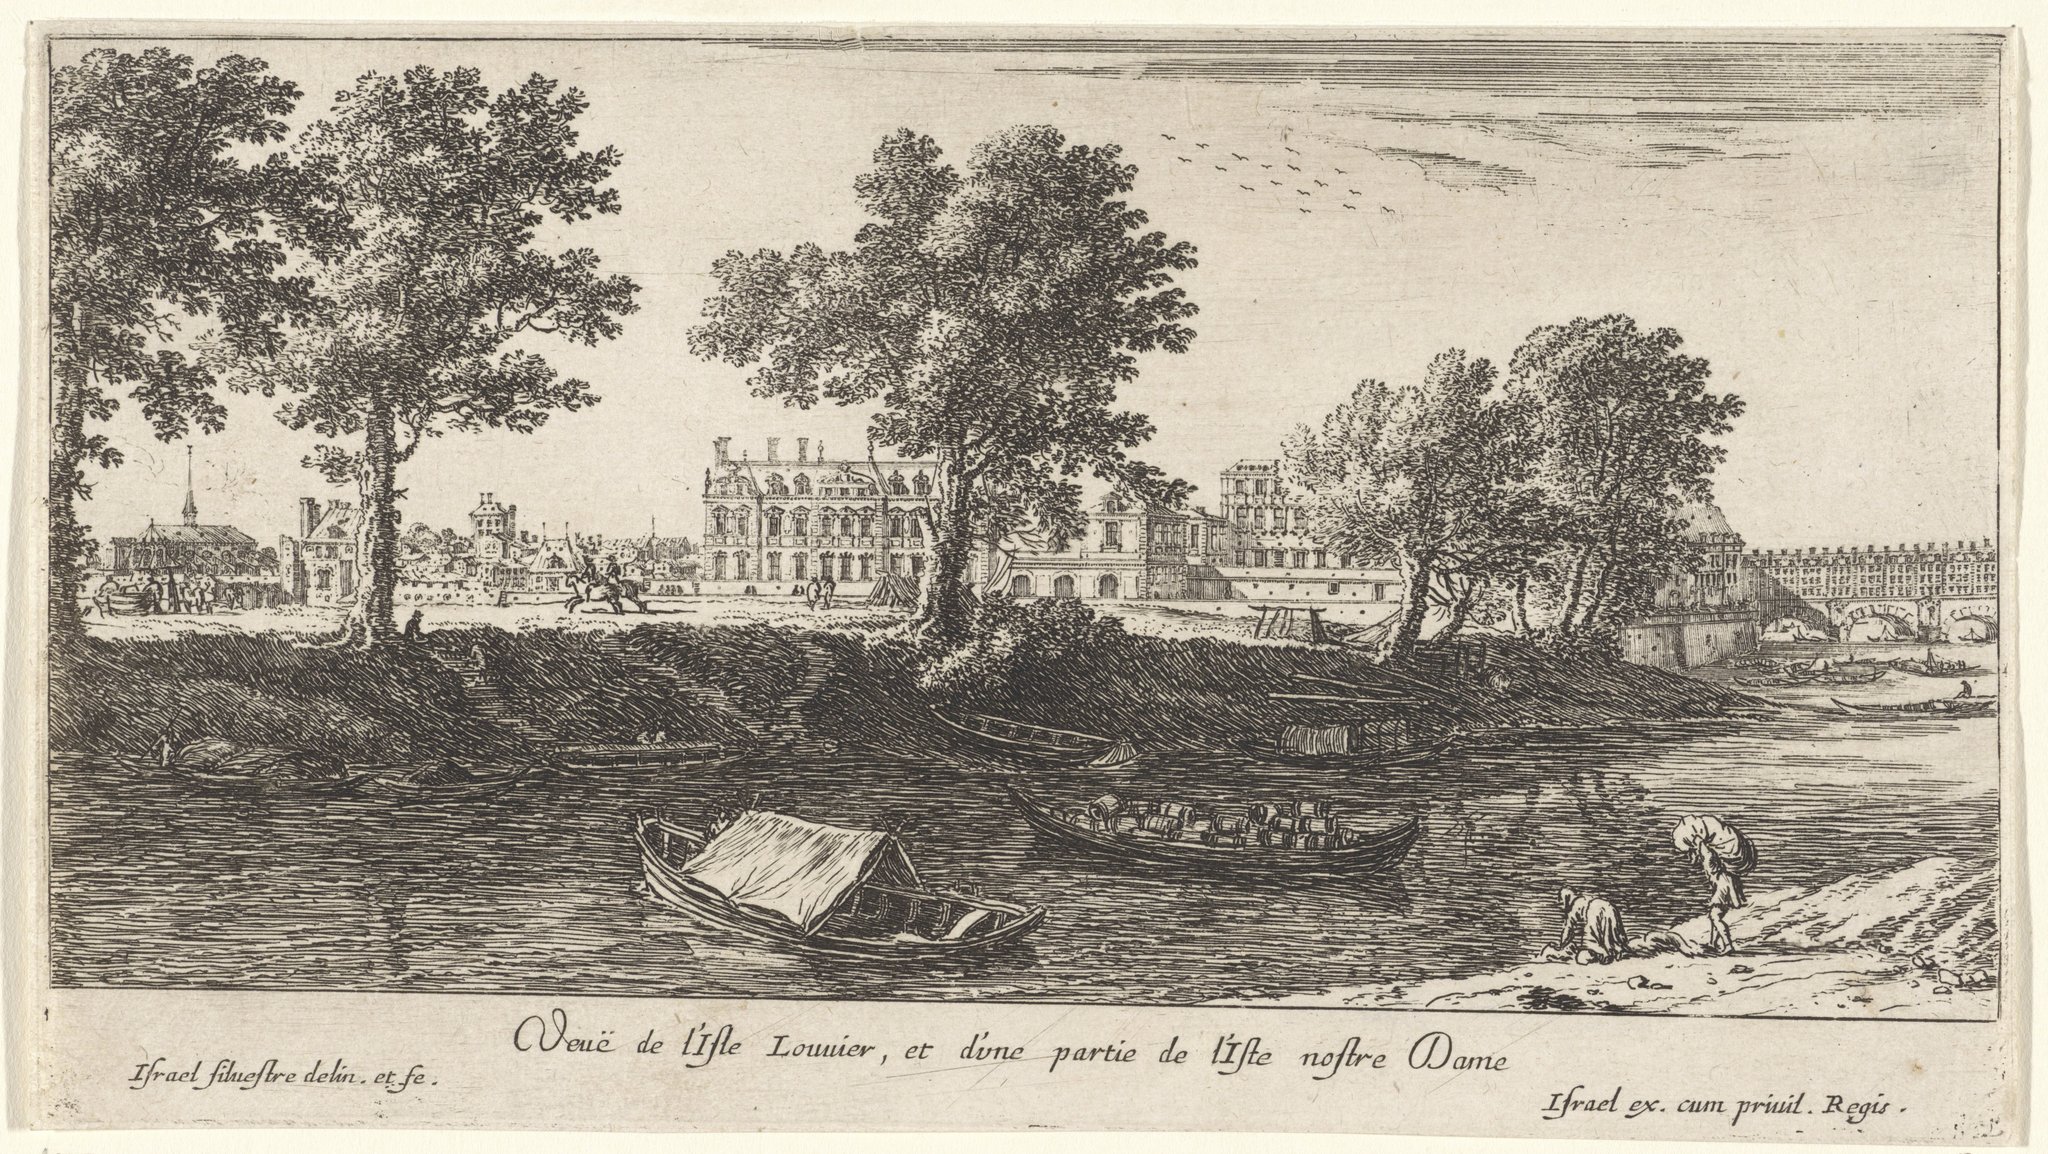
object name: print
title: Gezicht op het Île St. Louis te Parijs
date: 1650-1655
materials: paper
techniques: etching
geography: paris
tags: roman catholic church (+ mary), city-view in general; 'veduta'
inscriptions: collector's mark: Lugt 2228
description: Gezicht op het Île St. Louis te Parijs en een gedeelte van het Île de la Cité (op de prent aangeduid als Île Notre Dame) met de kathedraal Notre-Dame en enkele boten.